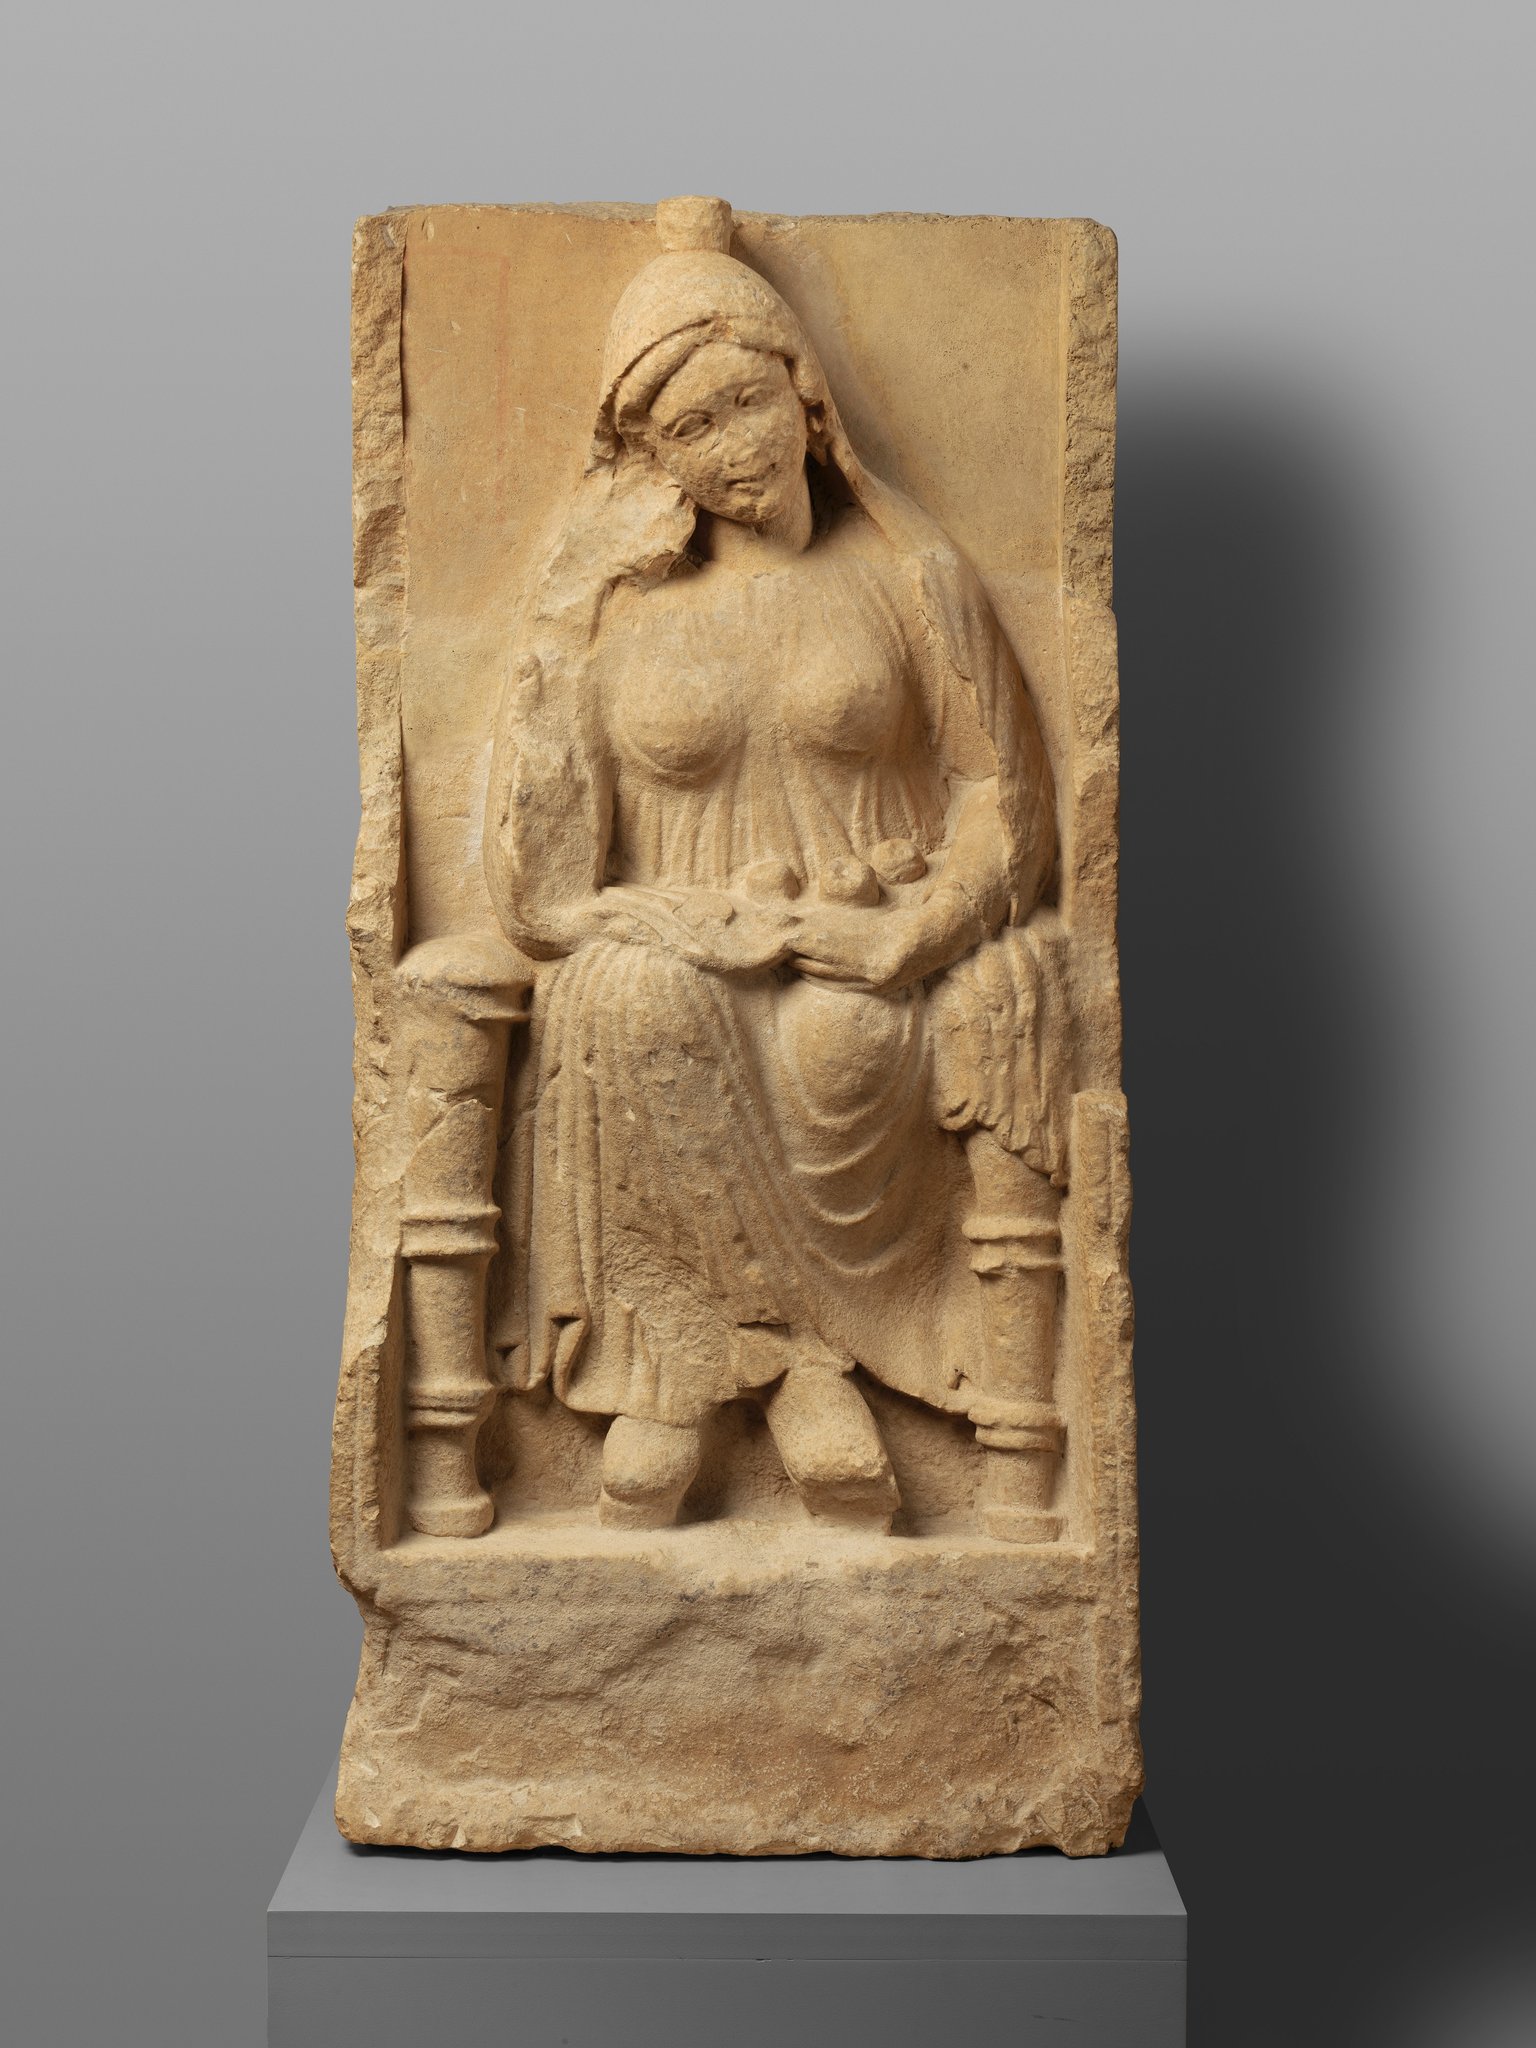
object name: grave stele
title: Limestone grave marker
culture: cypriot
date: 400-301 BCE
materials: limestone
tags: women